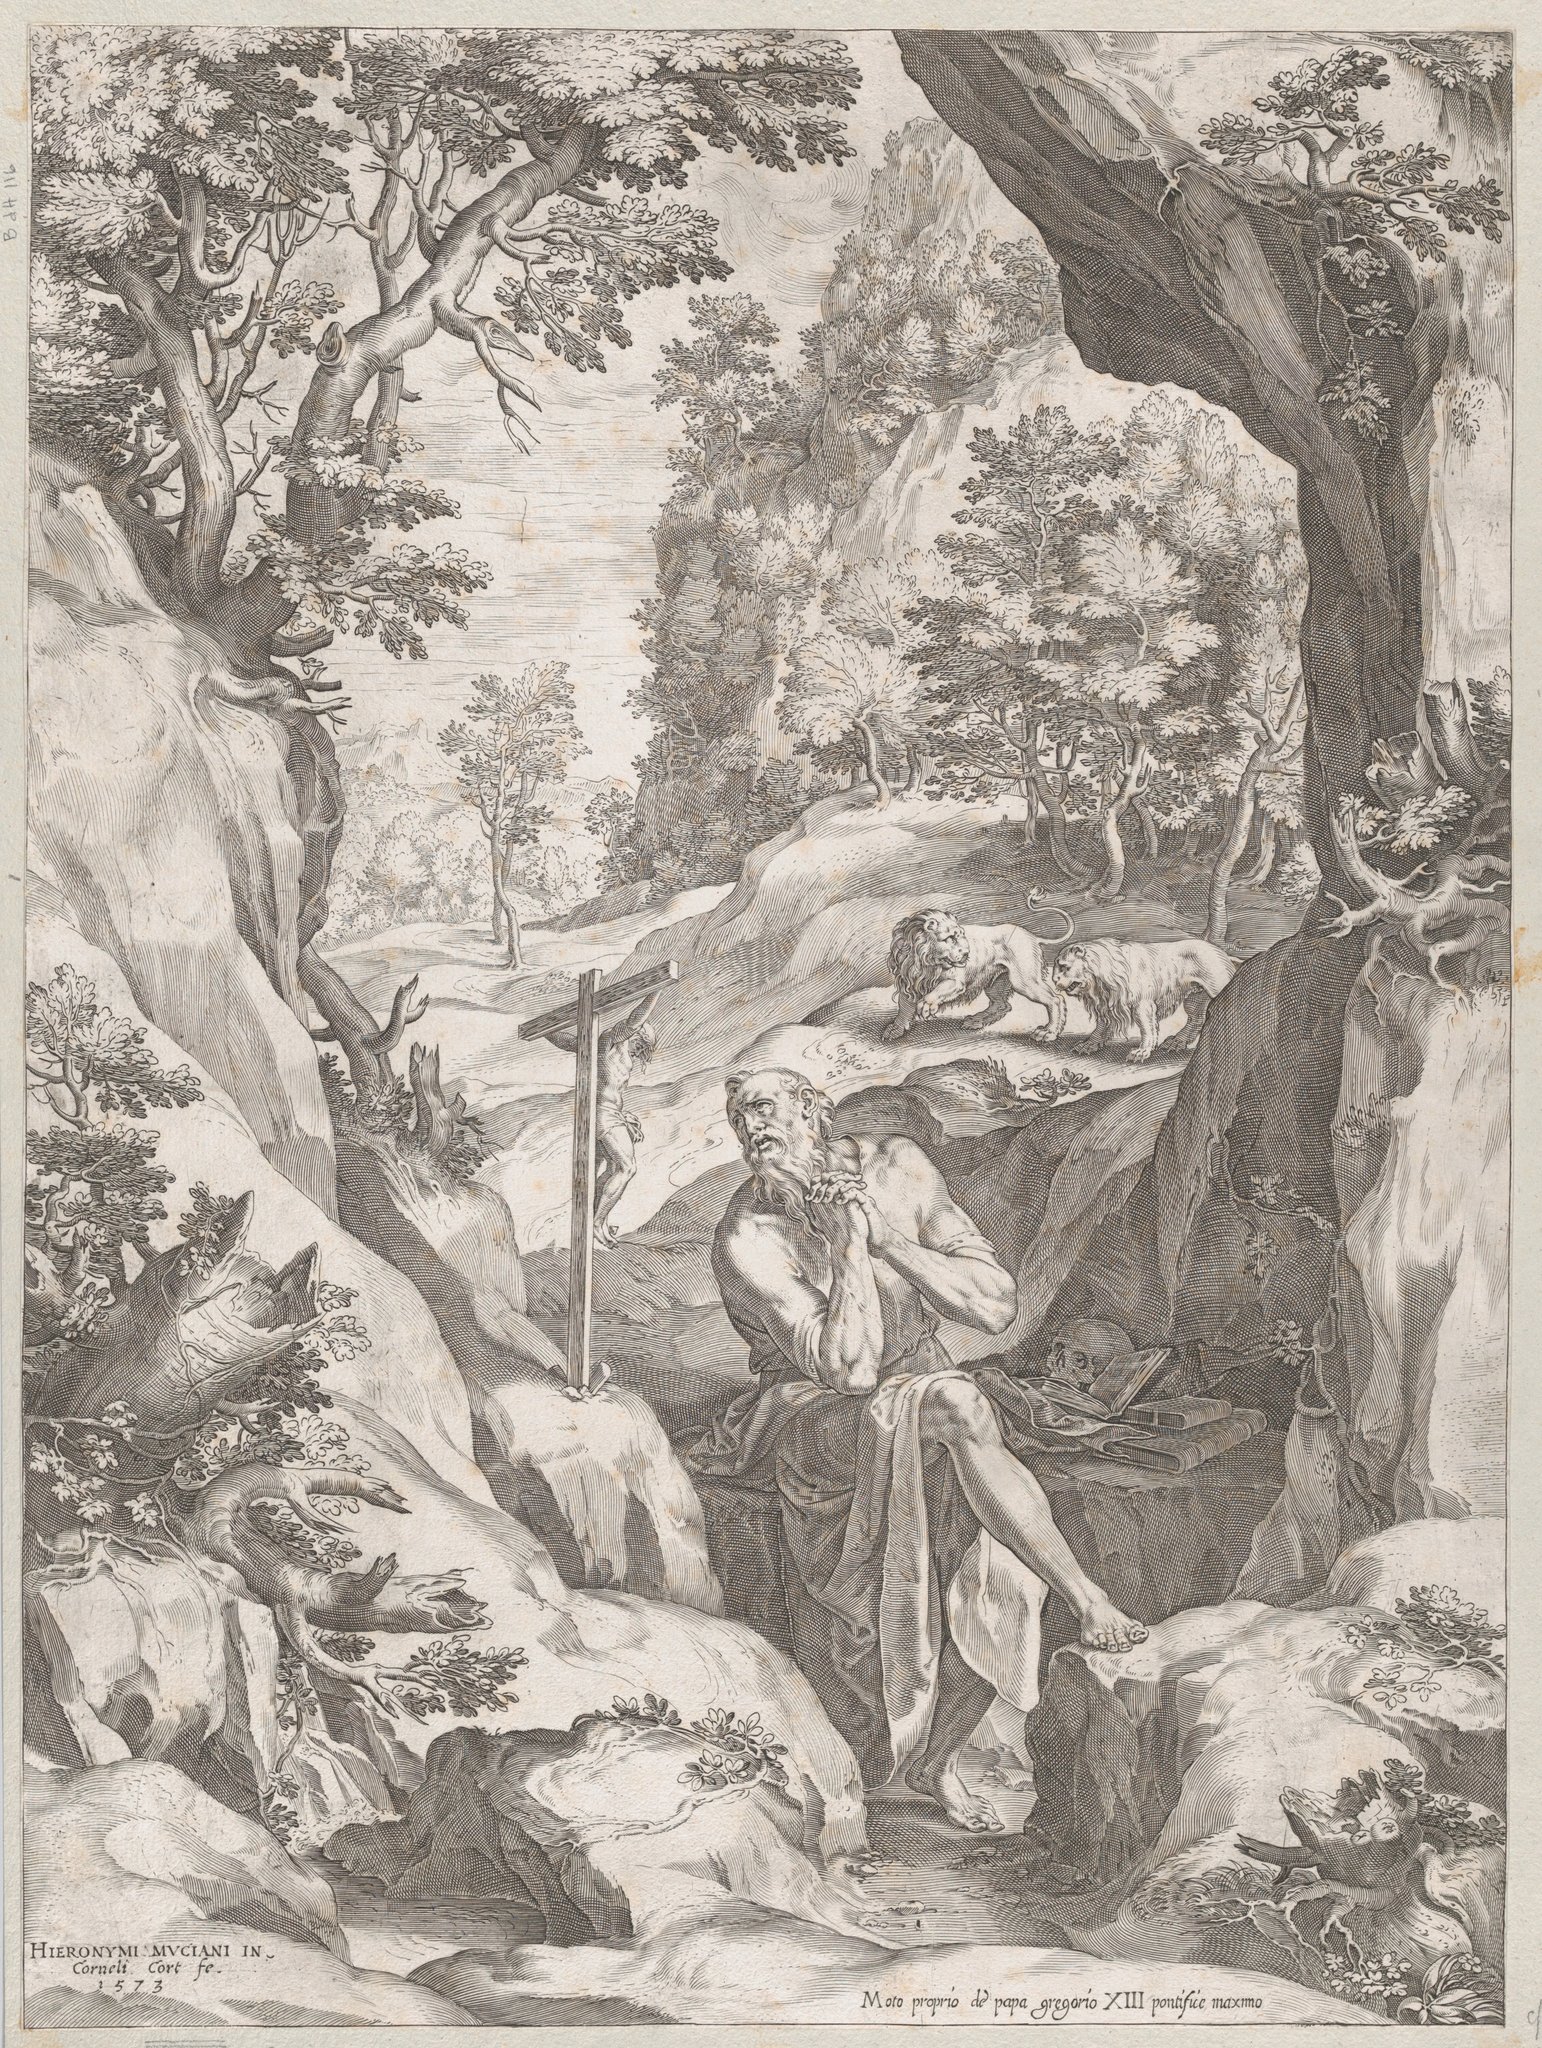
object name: print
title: St Jerome Penitent in the Wilderness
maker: cornelis cort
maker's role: artist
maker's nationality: netherlandish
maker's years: 1533-1578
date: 1573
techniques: engraving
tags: lions,trees,saint jerome,cross